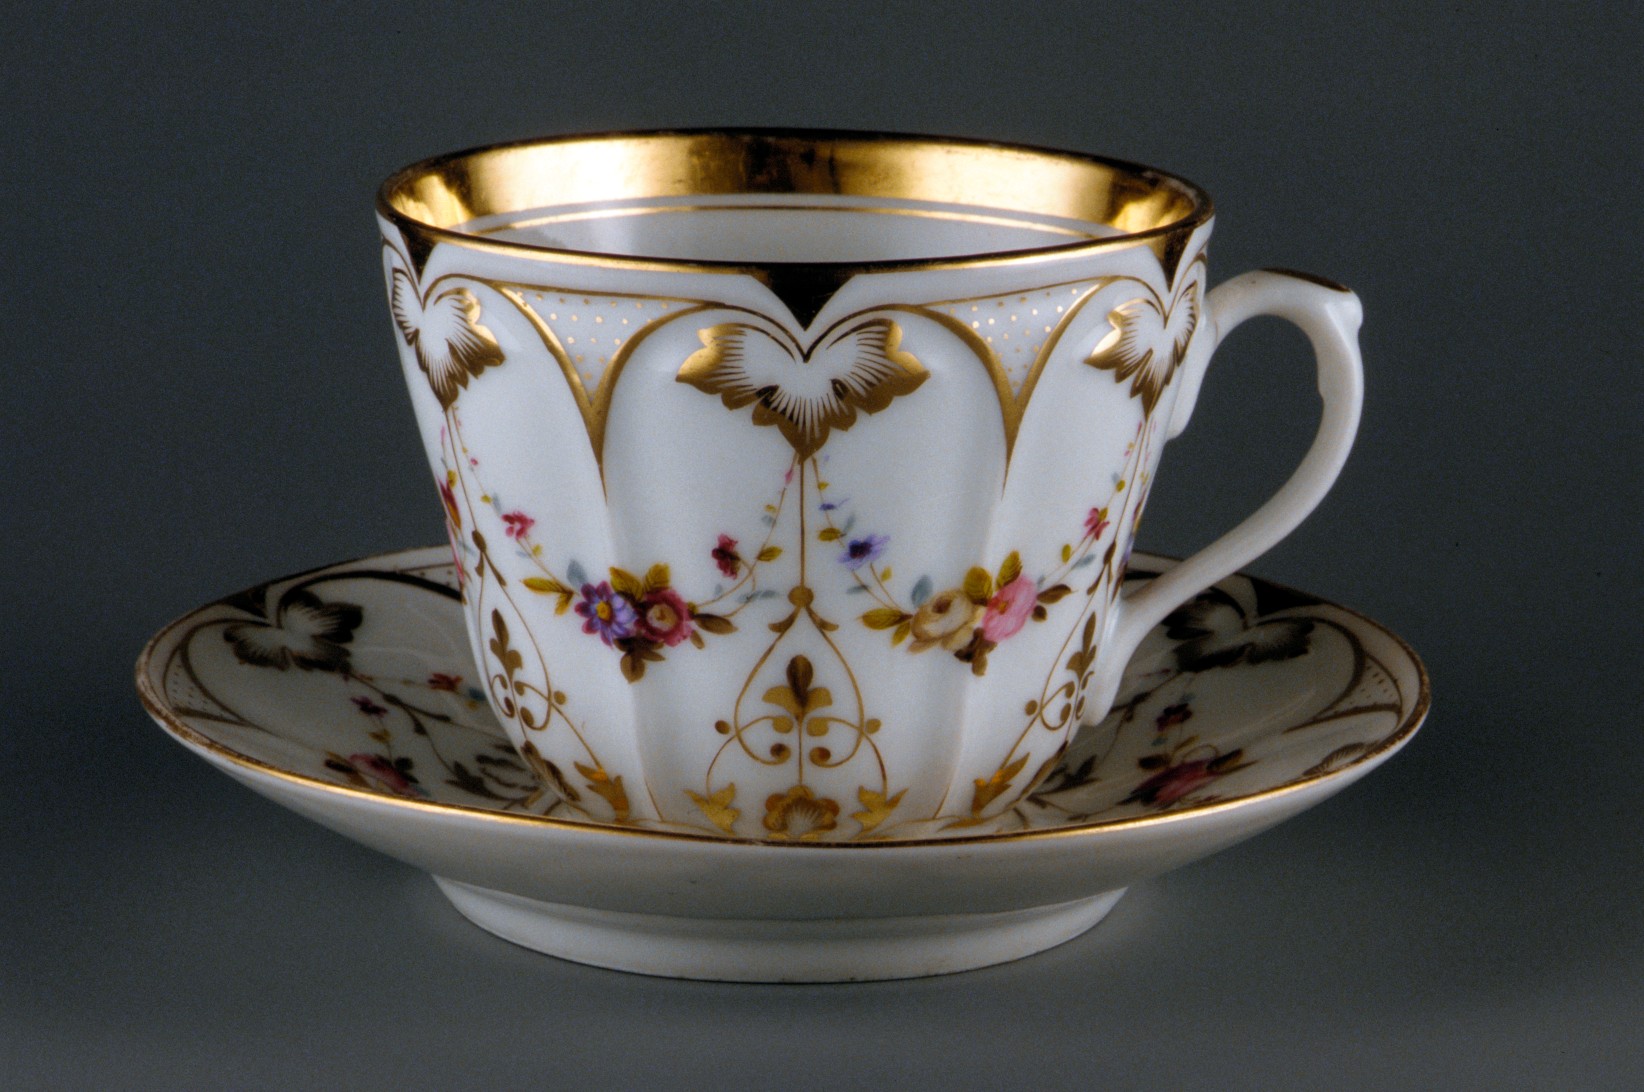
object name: saucer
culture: american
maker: charles cartlidge and company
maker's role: maker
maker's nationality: american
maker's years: 1848-1856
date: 1848-1856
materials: porcelain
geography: united states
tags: flowers